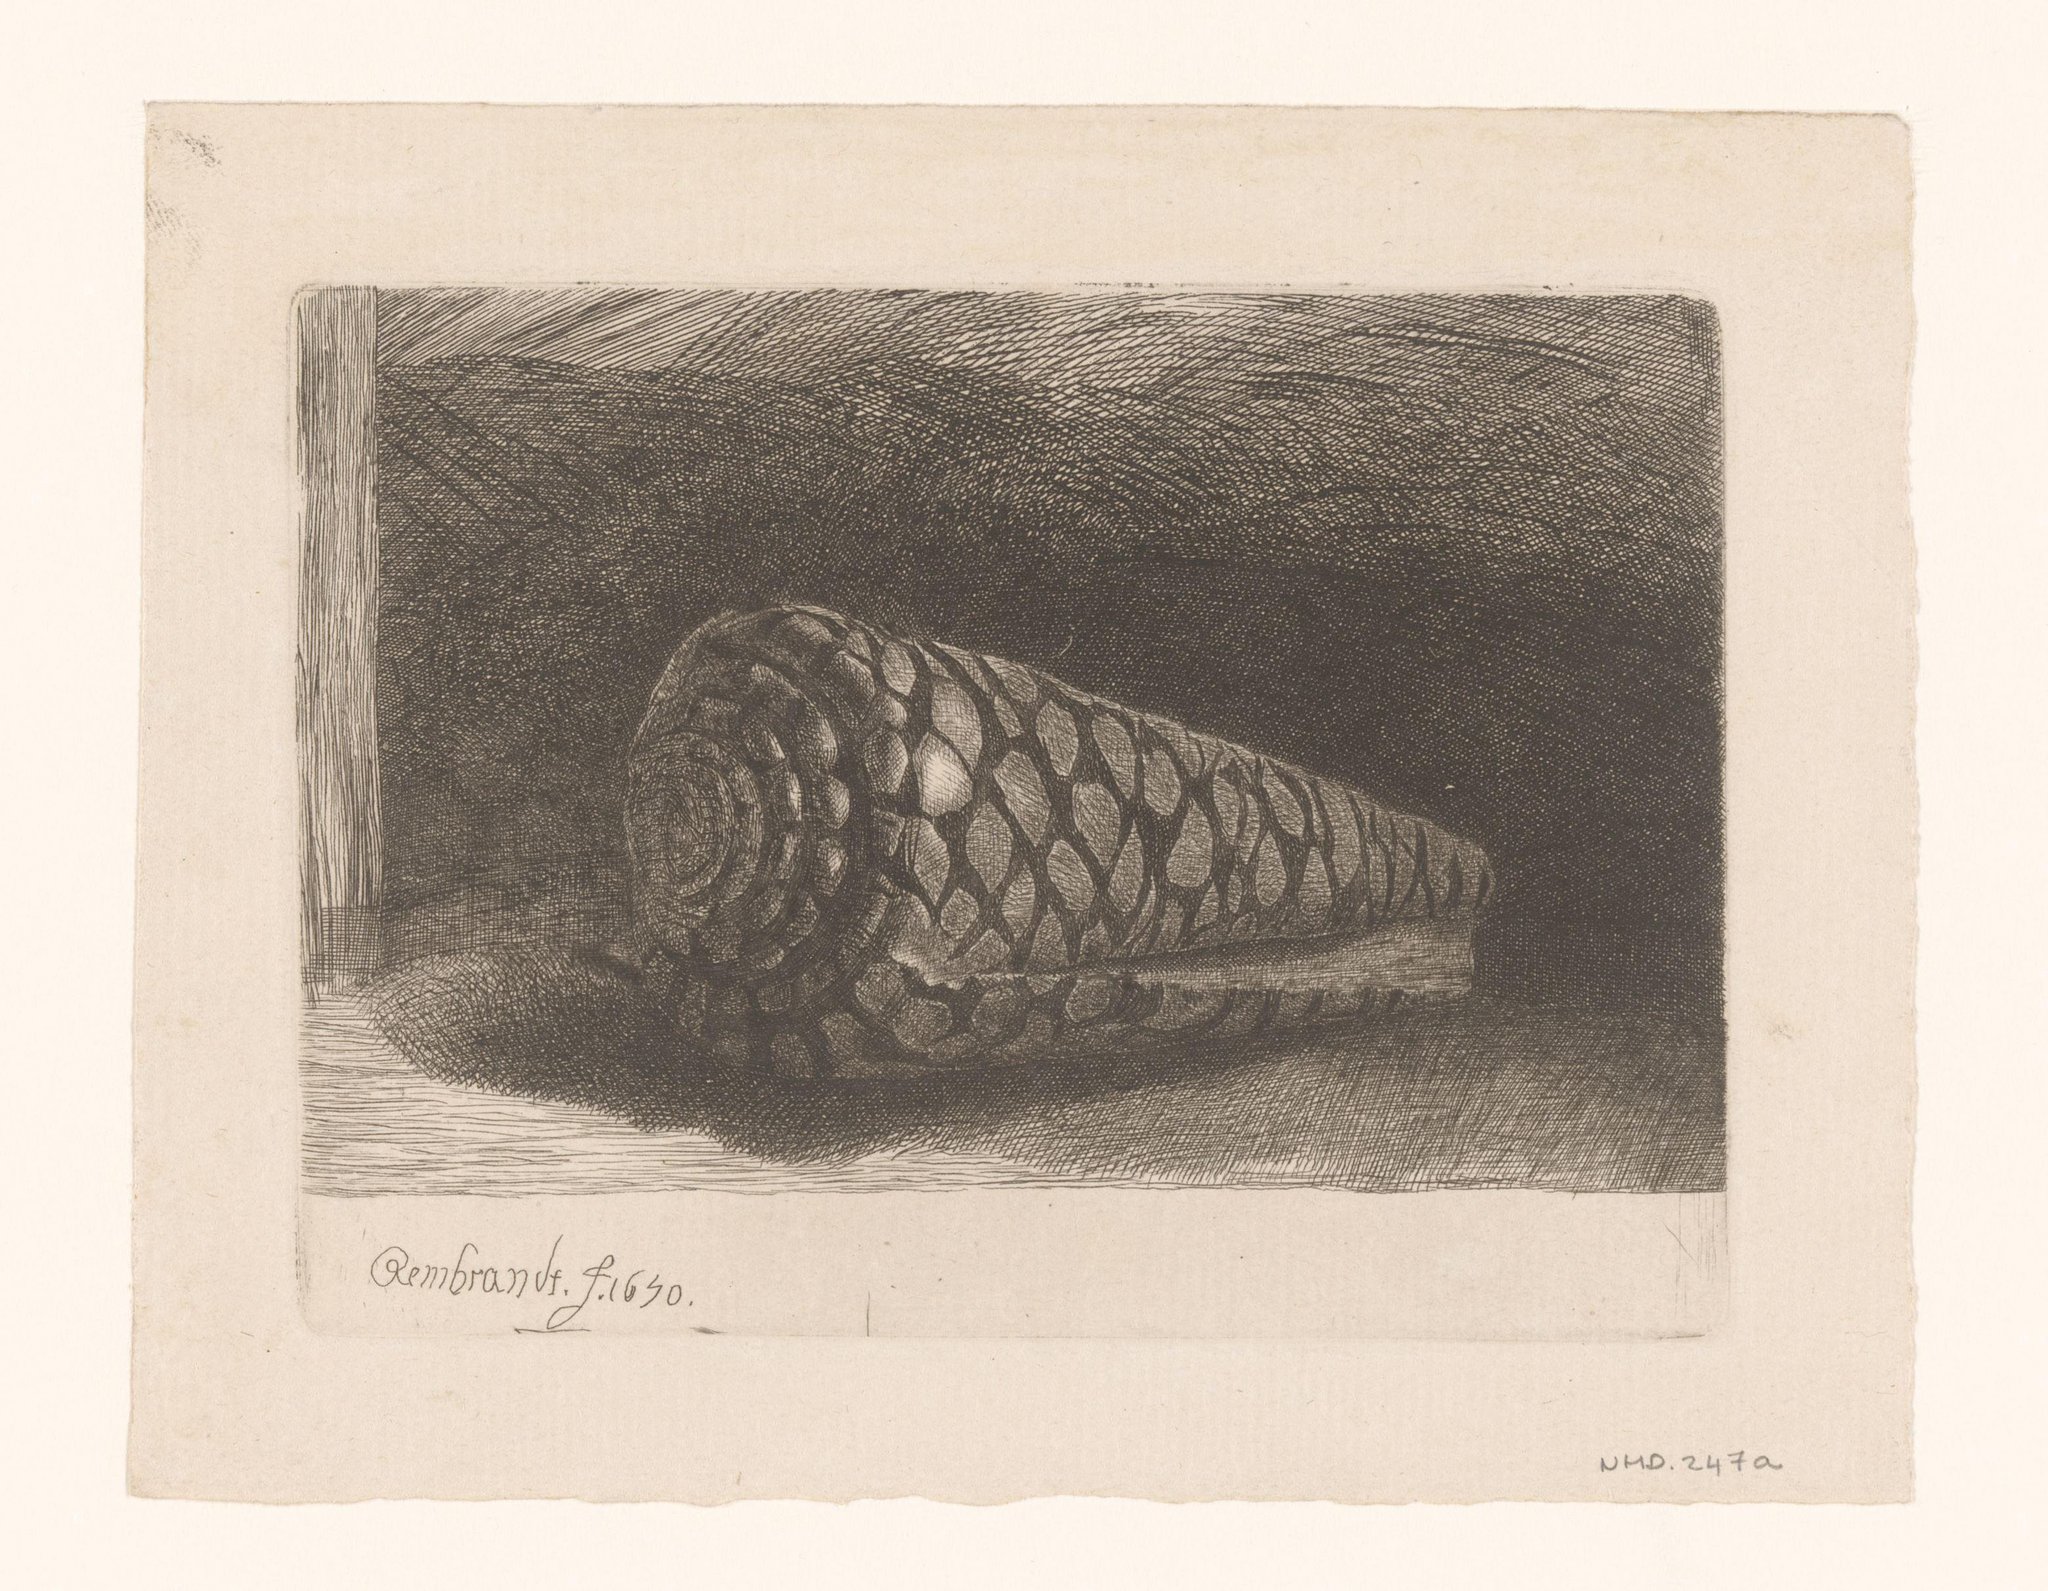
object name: print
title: The shell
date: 1700-1758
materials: paper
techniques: etching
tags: molluscs (+ shell, snail-shell etc.)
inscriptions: collector's mark: Lugt 4071, collector's mark: Lugt 2228, collector's mark: Lugt 2760